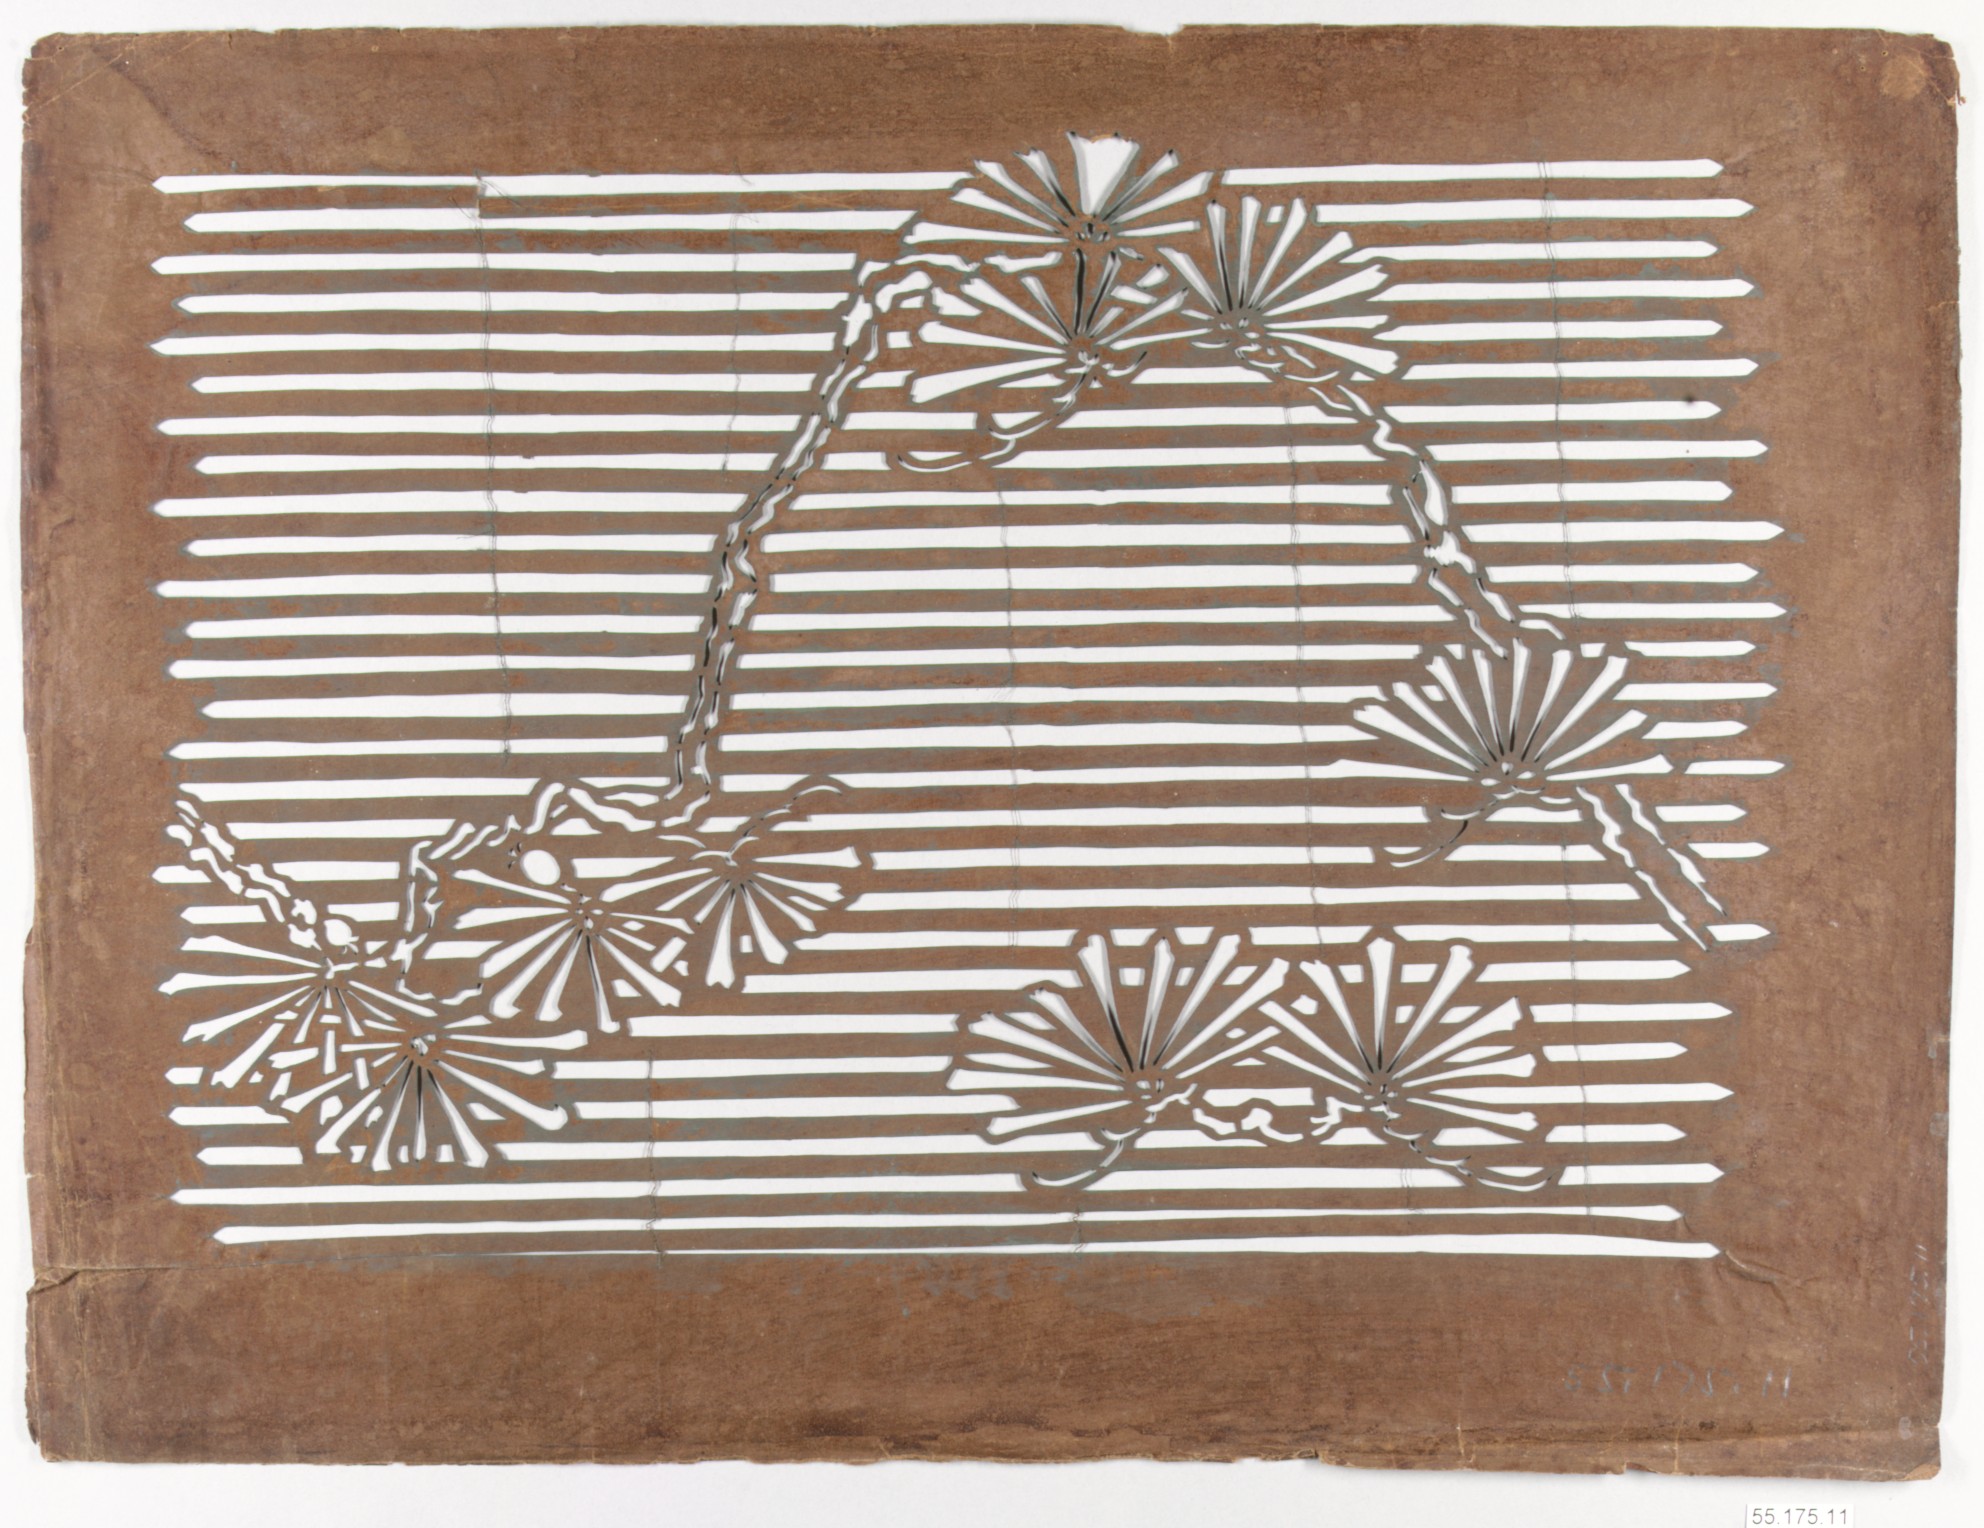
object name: stencil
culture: japanese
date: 1801-1900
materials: paper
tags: flowers